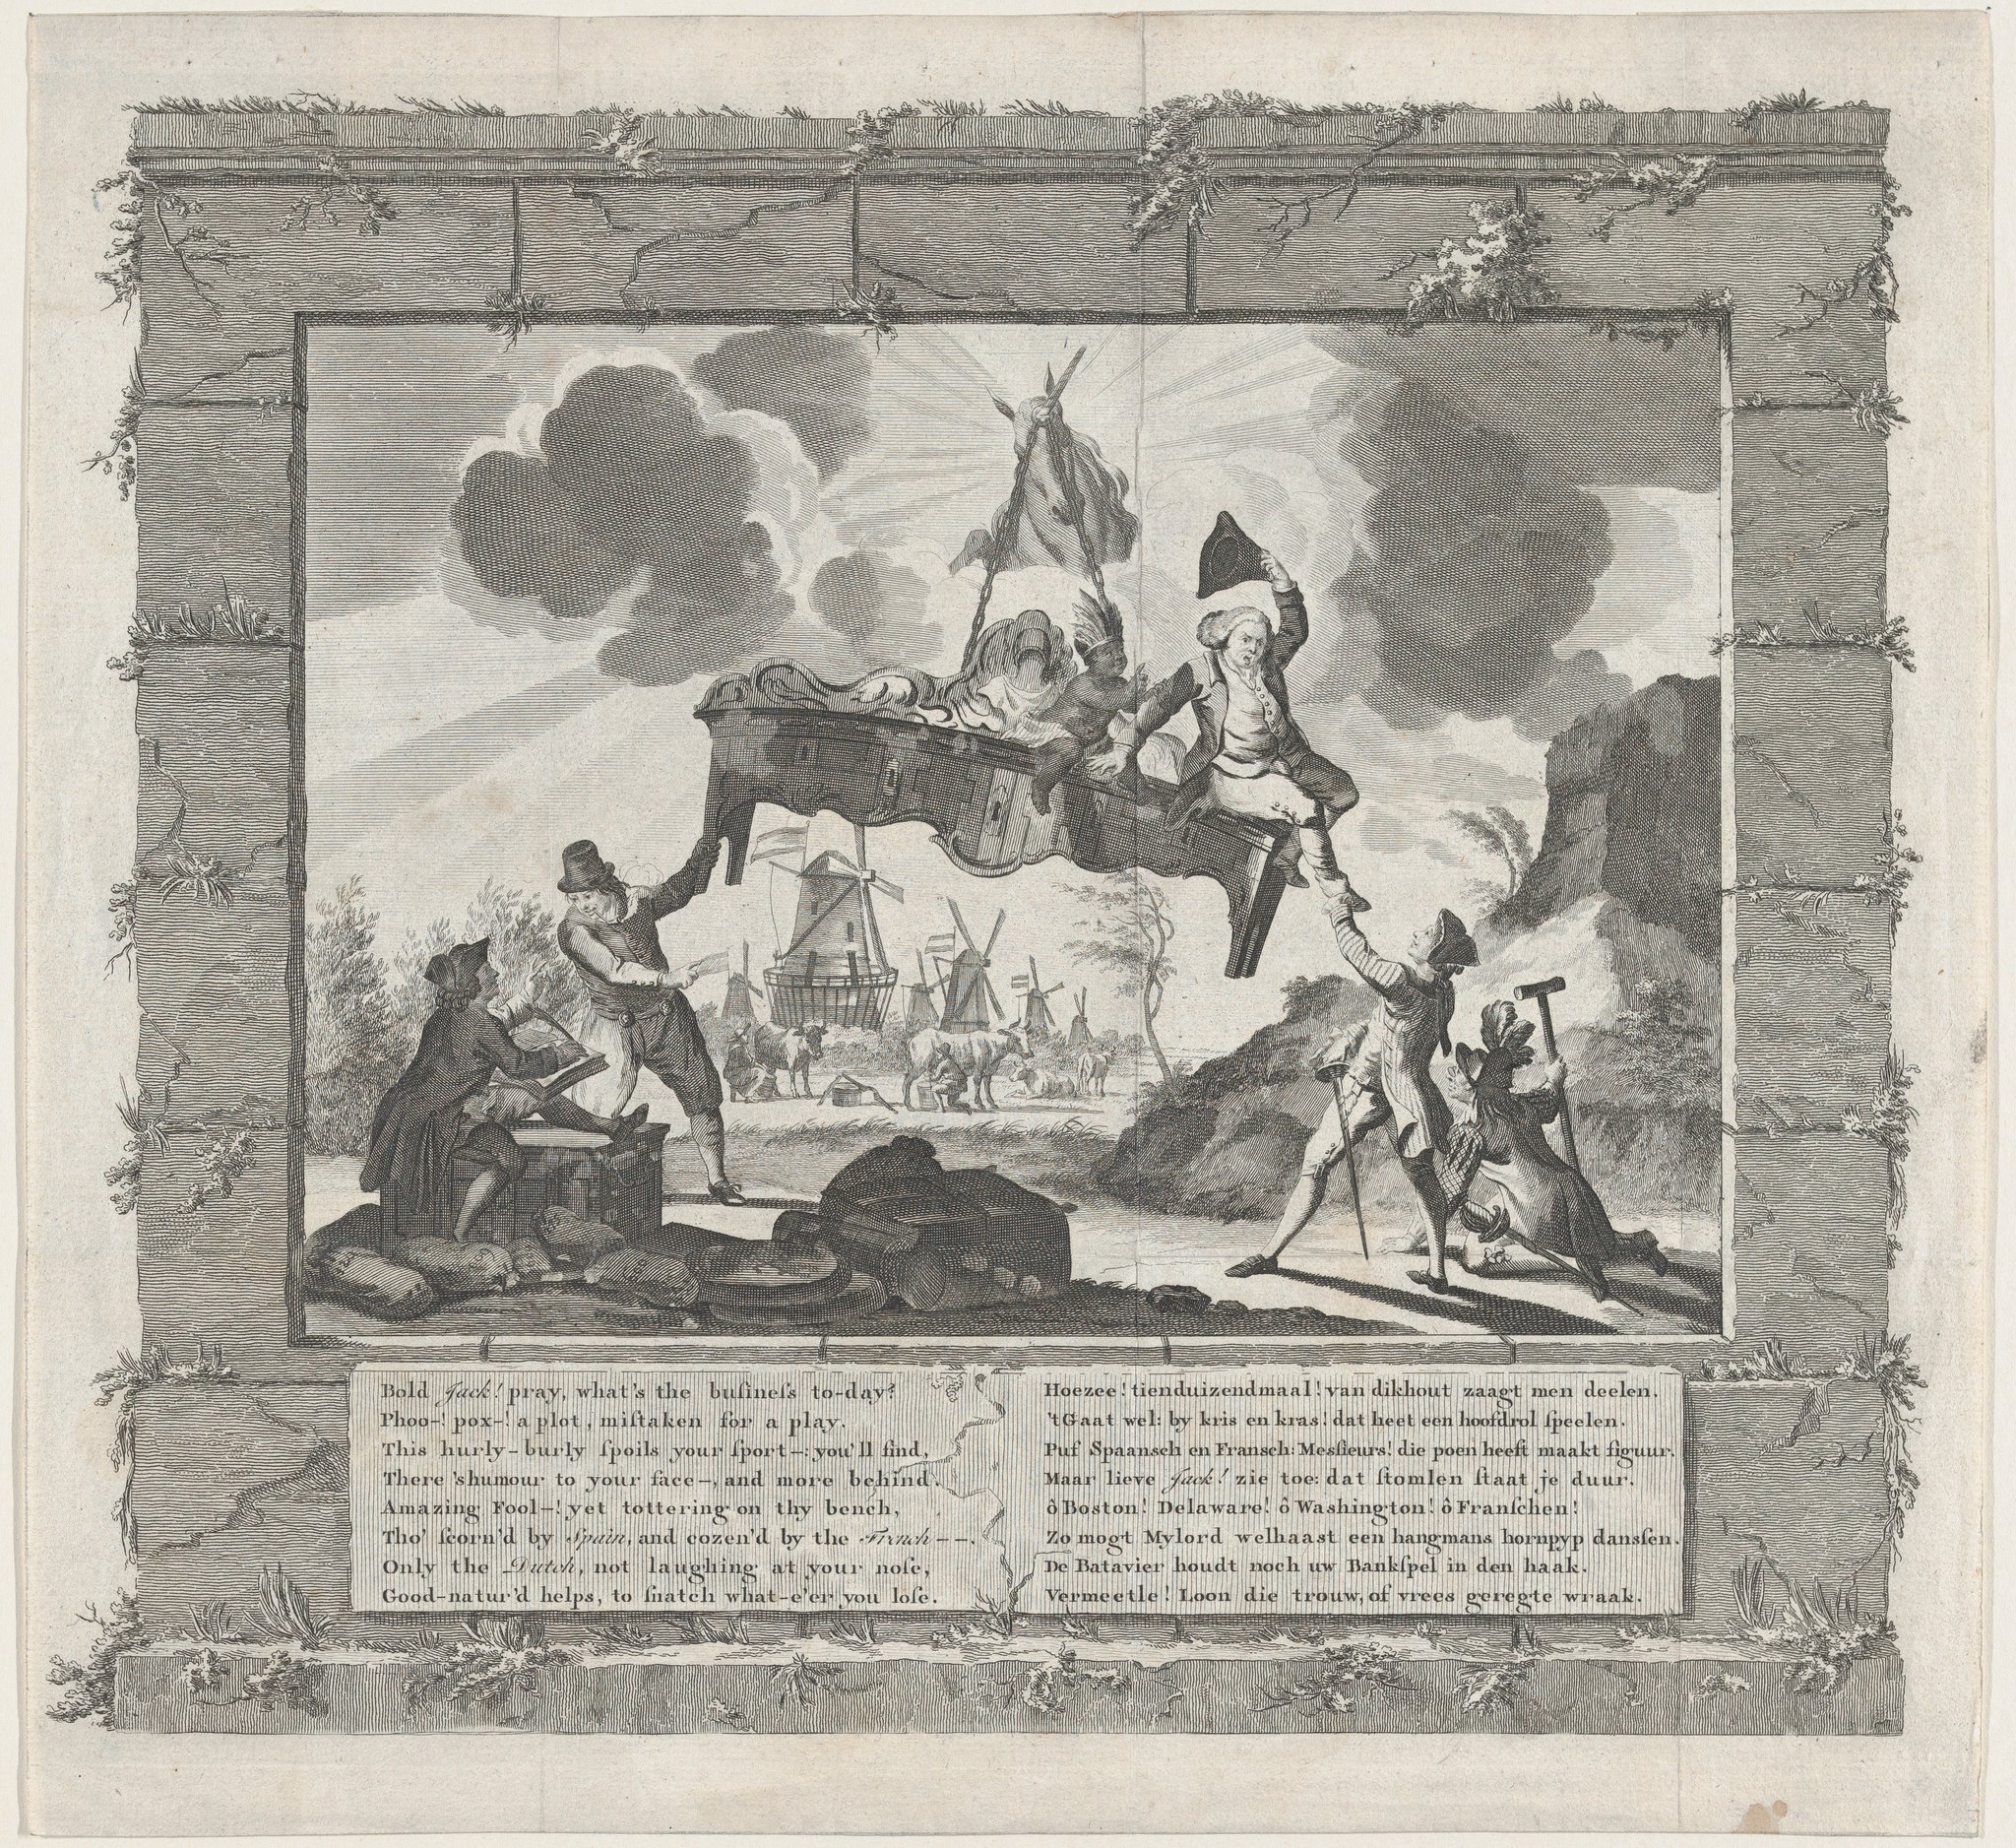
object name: print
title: Het Tegenwoordig Veward Europa [Europe in Her Present Disordered State]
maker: anonymous, dutch, 18th century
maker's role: artist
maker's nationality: dutch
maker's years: 1700-1800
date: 1780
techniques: engraving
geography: netherlands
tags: satire,american revolution,men,women,politics